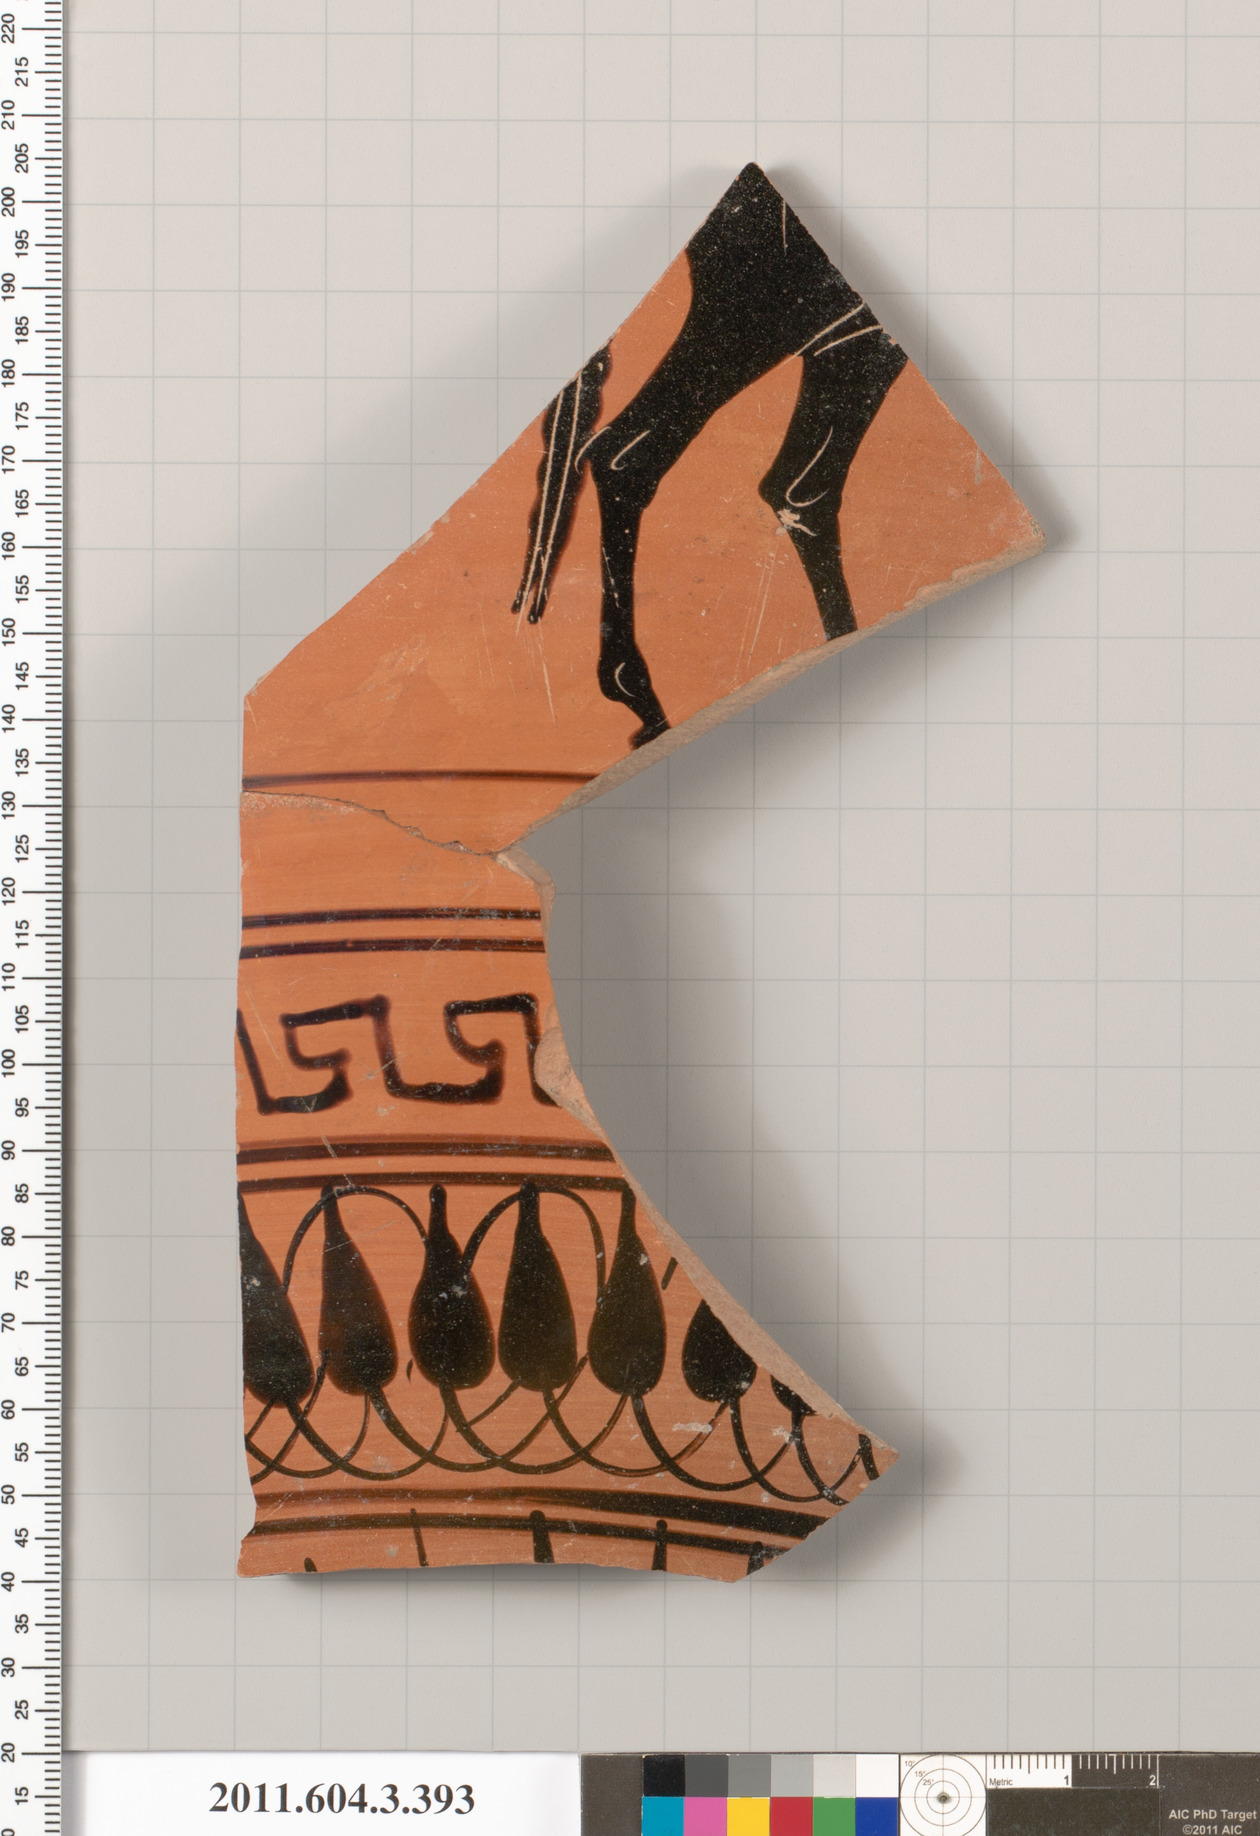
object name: neck amphora fragment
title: Terracotta fragment of a neck-amphora (jar)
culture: greek, attic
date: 520 BCE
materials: terracotta